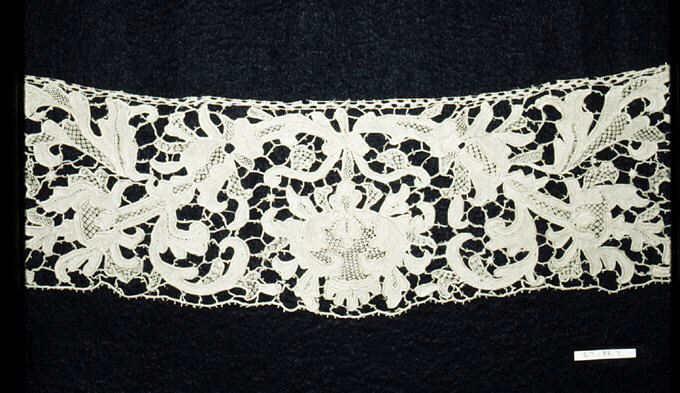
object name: strip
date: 1667-1700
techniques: lace